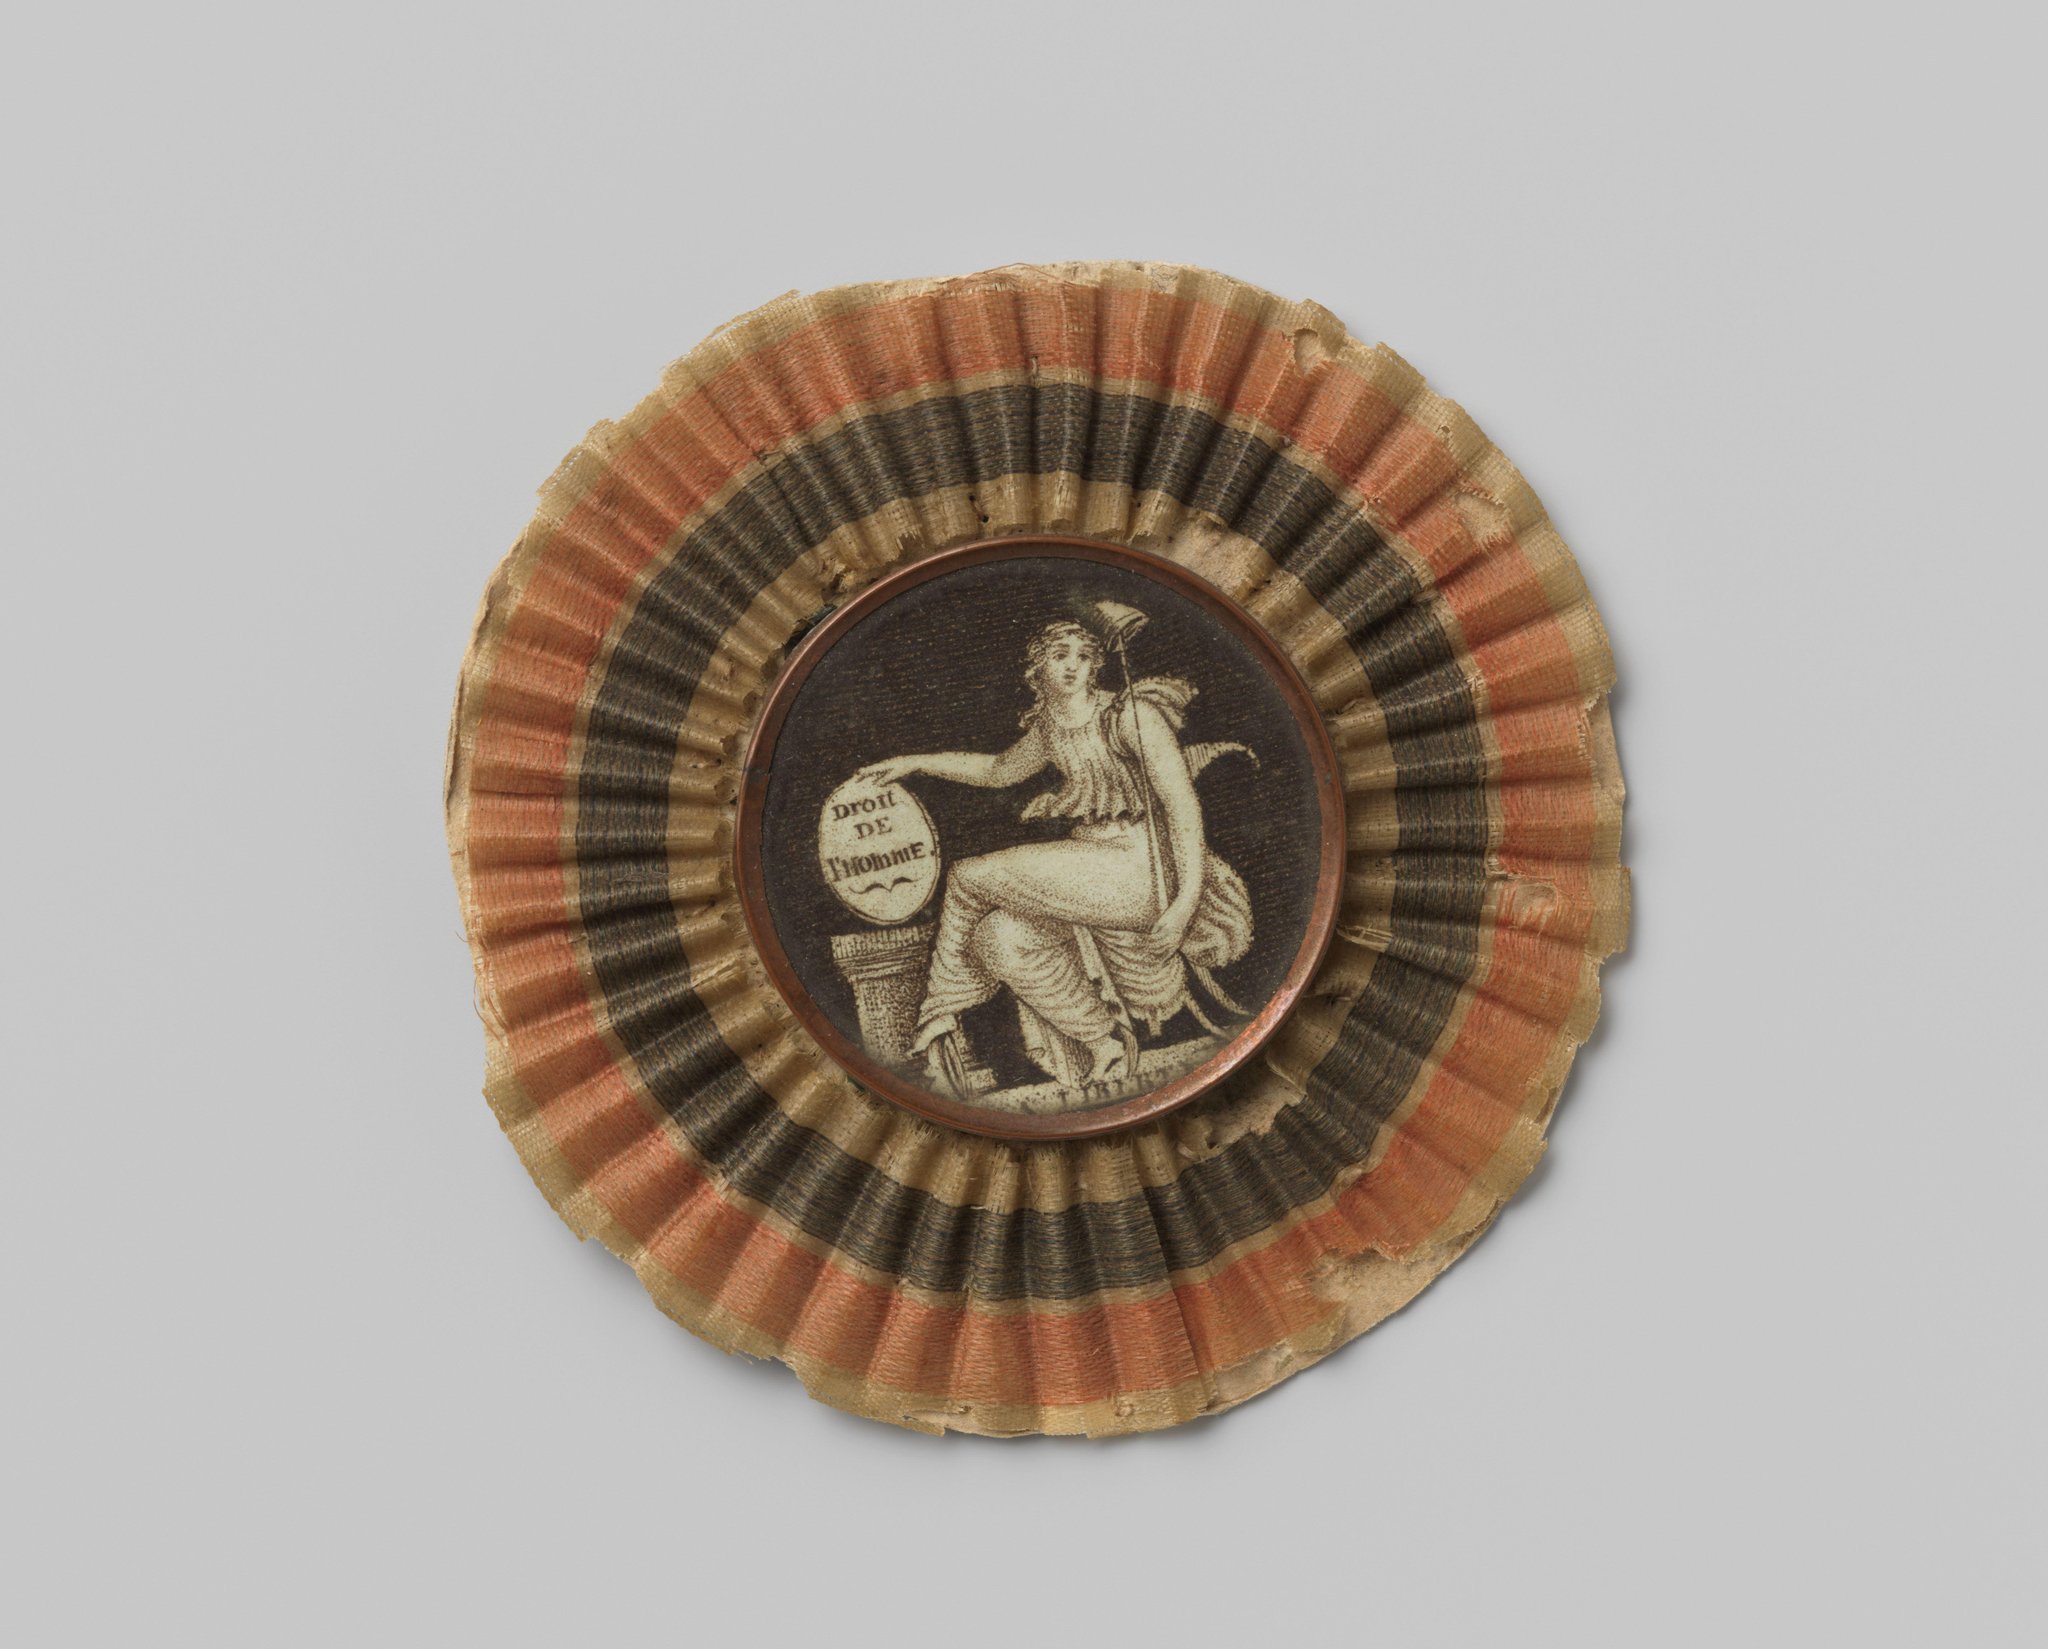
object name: rosette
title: Rozet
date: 1795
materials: copper, glass, paper, silk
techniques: engraving, stitching, striking, weave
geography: netherlands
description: Rond draagteken op papier, waarvan de buitenrand bestaat uit rood-wit-blauwe zijde. In het midden een koperen medaillon waarin op papier achter glas de afbeelding van de zittende vrijheidsmaagd met staf en hoed in linkerhand, haar rechterhand rustend op een ovaal schild dat op een halve zuil staat. keerzijde: zijden bevestigingslintje. Opschrift; op schild: Droit / DE / L'HOMME. onder: LA LIBERTE.